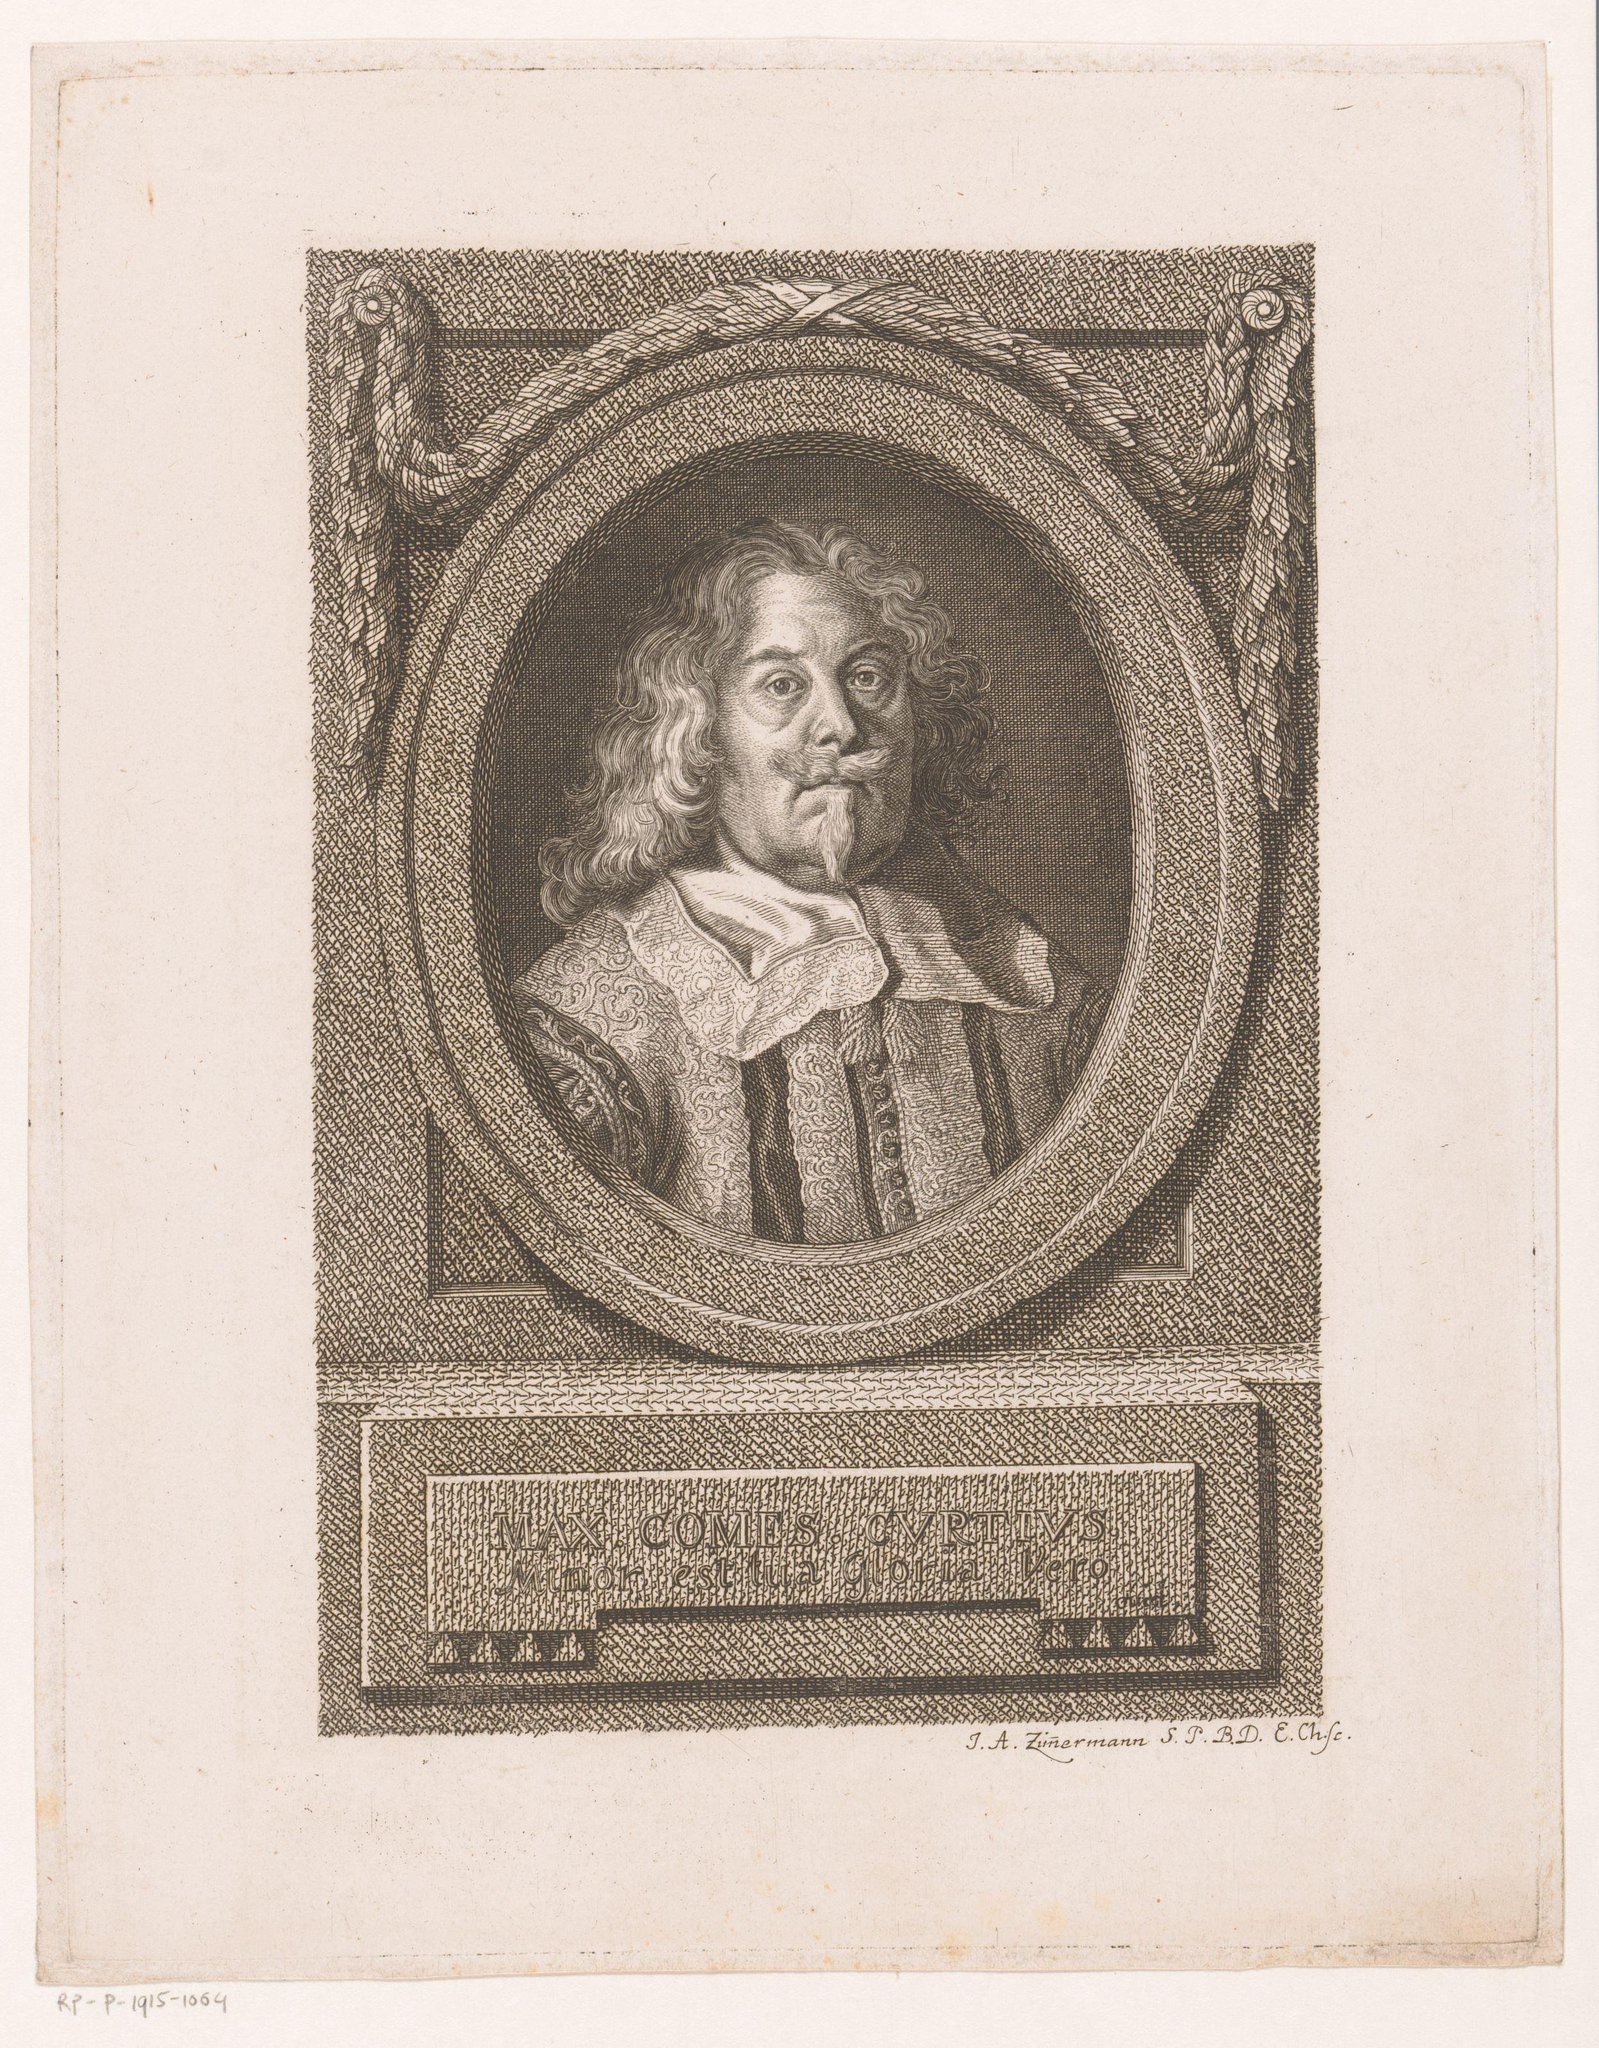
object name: print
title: Portret van Maximilian Kurtz von Senftenau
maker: joseph anton zimmermann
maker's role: draughtsman, print maker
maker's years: 1705-1797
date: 1715-1797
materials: paper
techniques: engraving, etching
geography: germany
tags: politician, historical persons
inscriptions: collector's mark: Lugt 2228